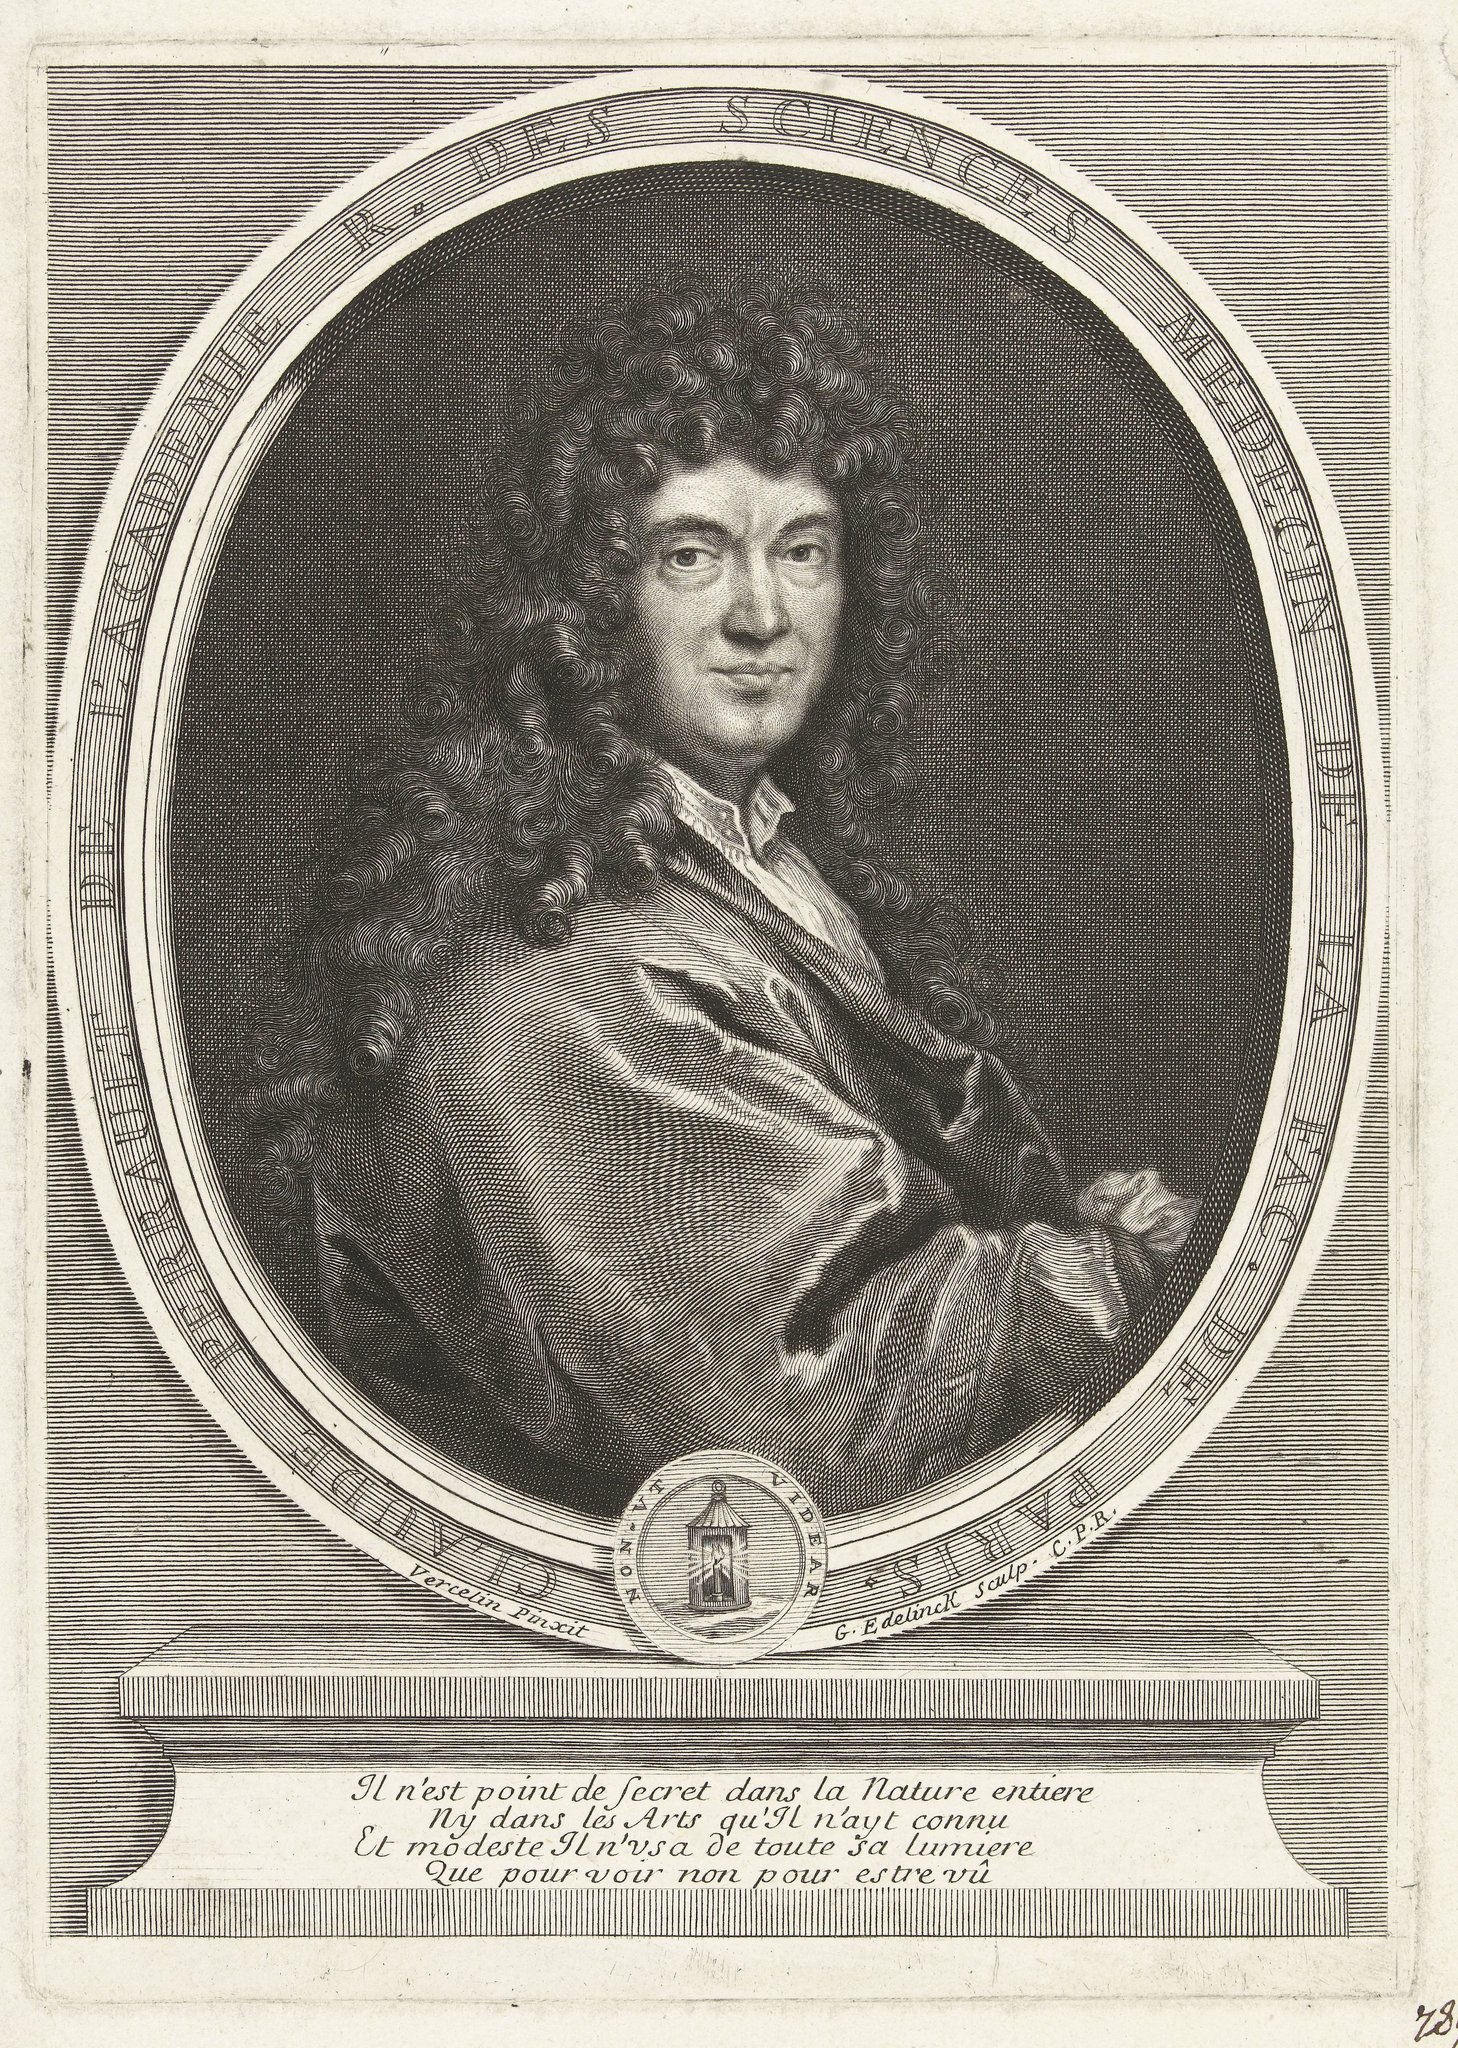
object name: print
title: Portret van Claude Perrault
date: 1666-1707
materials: paper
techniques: engraving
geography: france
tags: paris, print maker, claude perrault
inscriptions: collector's mark: Lugt 240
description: Portret van de Franse architect en medicus Claude Perrault (1613-1688), afgebeeld in ovale omlijsting met tekst in Latijn en rond embleem. Onder de lijst een console waarop een Frans vers van vier regels.